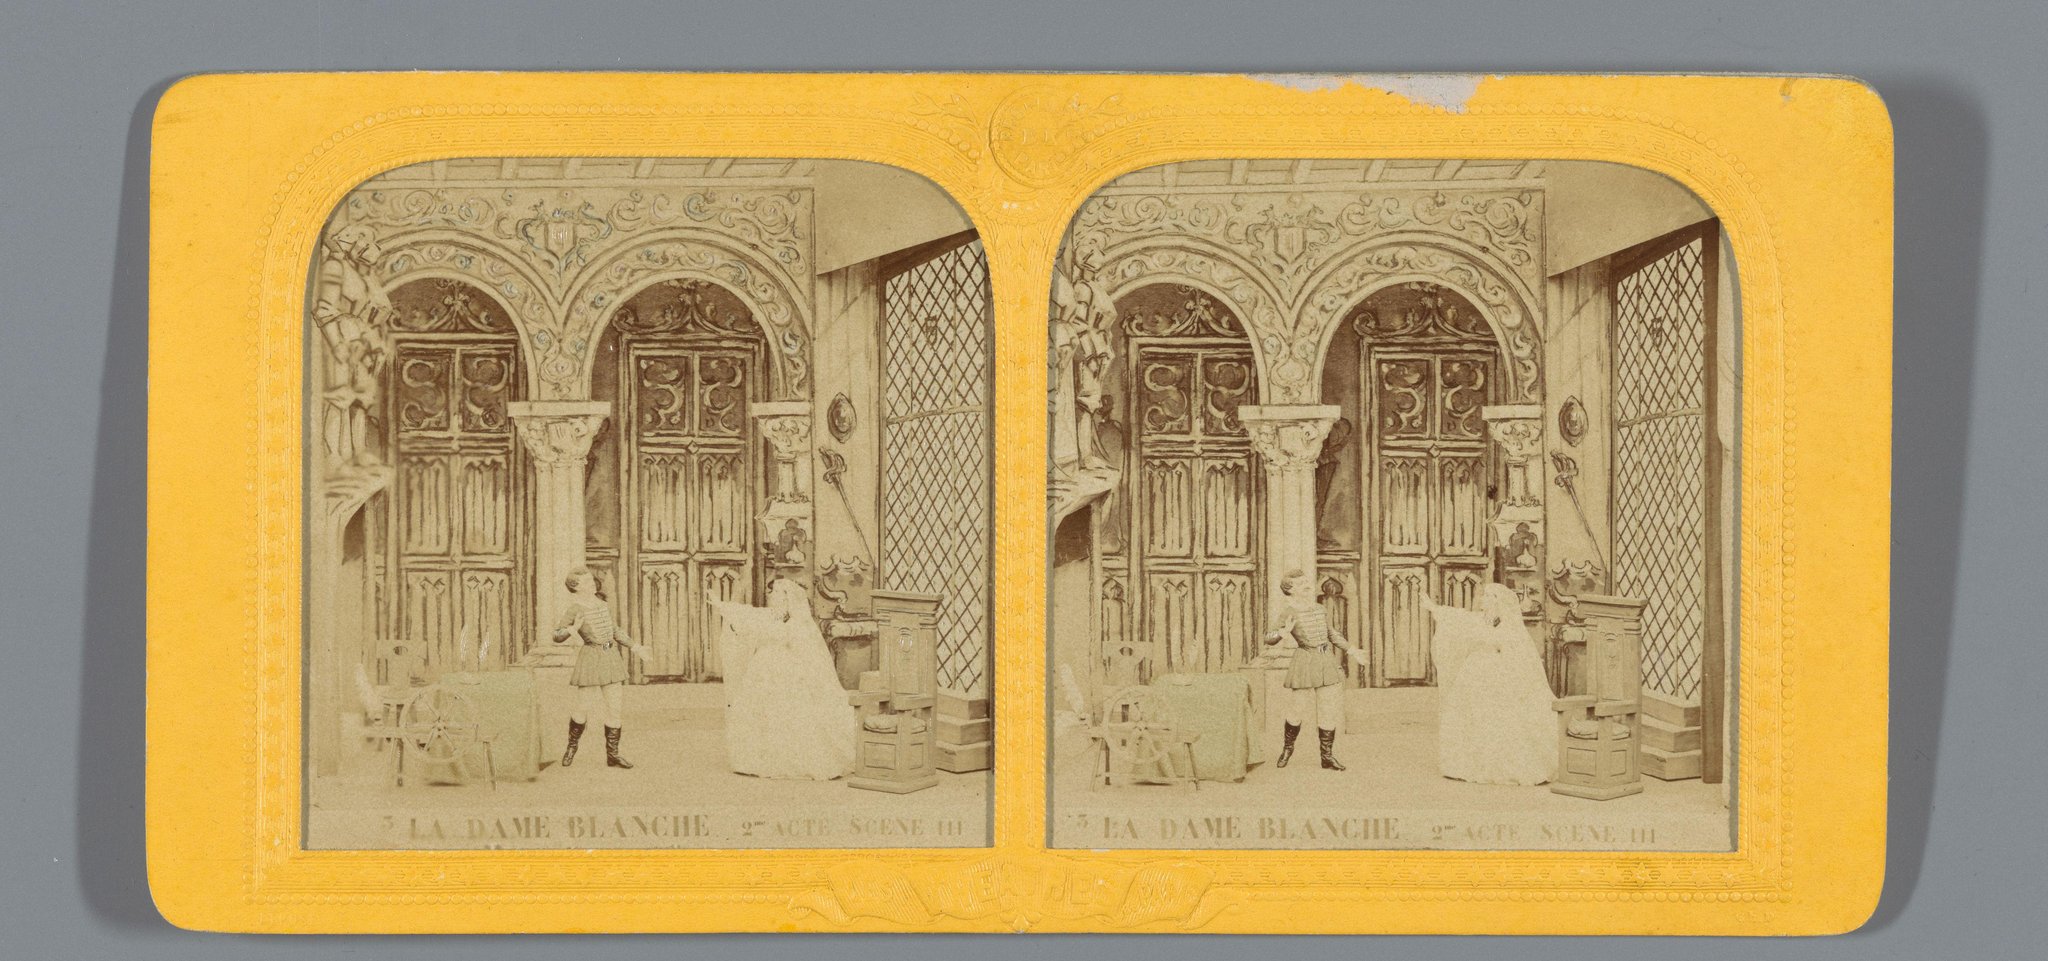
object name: stereograph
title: La dame blanche II acte scene 3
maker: Anonymous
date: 1867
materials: cardboard, photographic support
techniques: albumen print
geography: paris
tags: group of actors, troupe; actors on the stage, paris